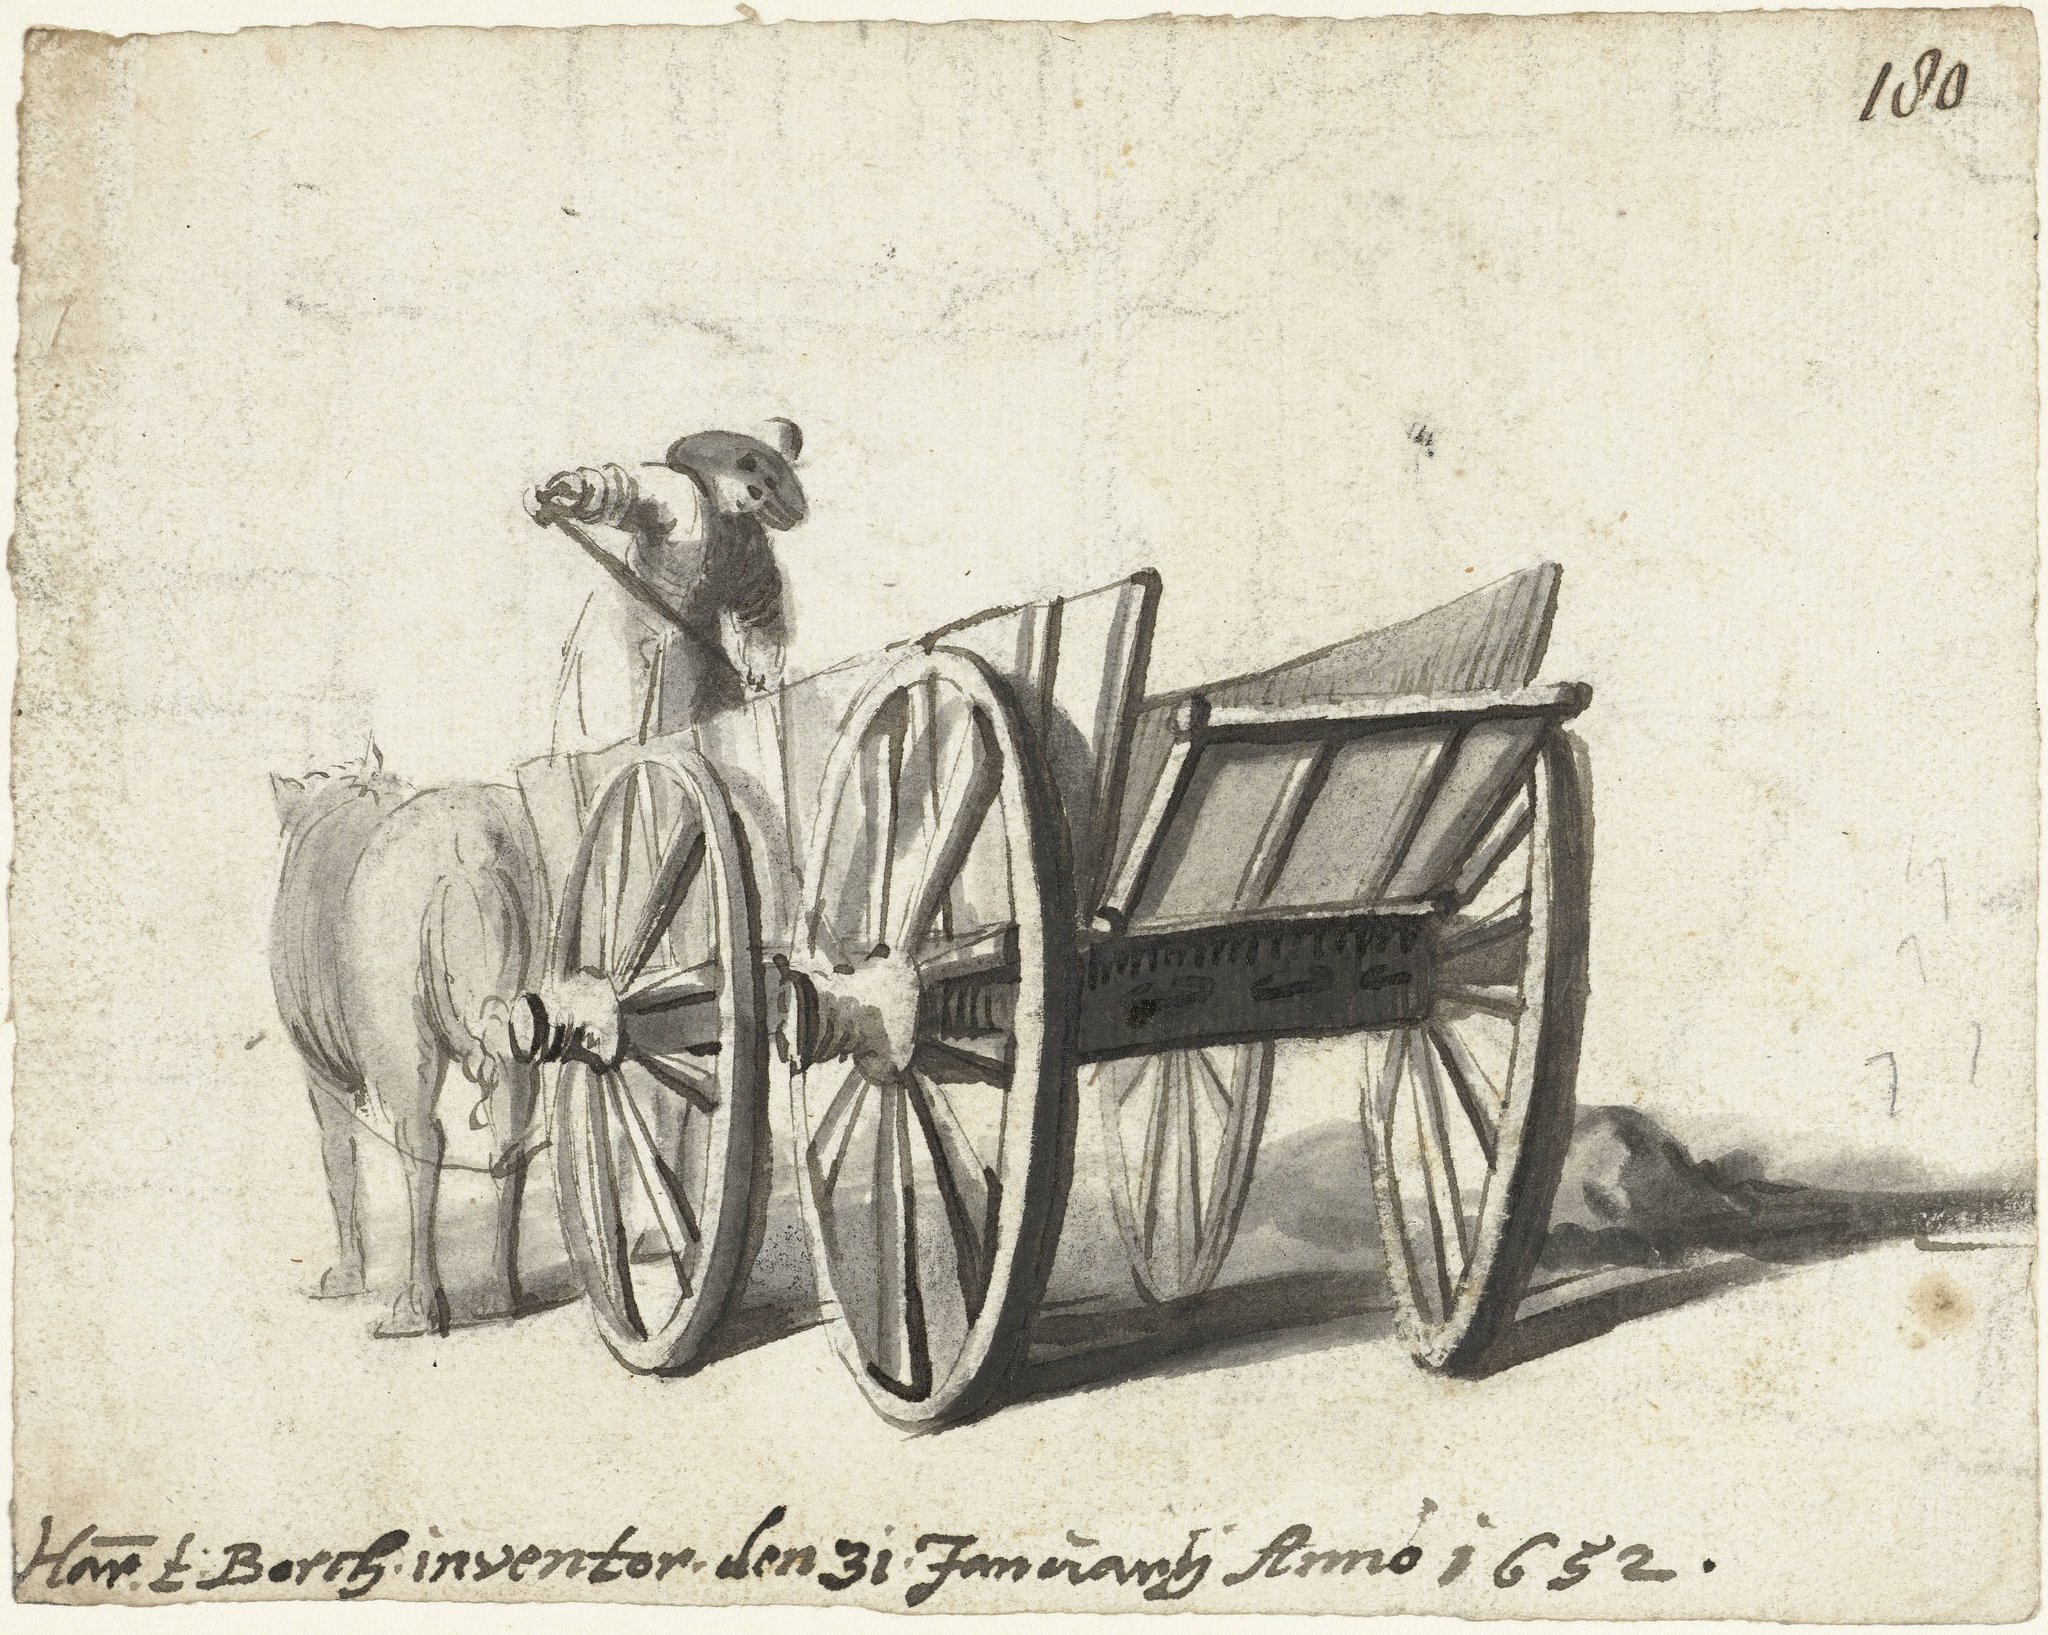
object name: drawing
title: Man werkend op een kar met paarden ervoor (mest scheppend?)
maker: harmen ter borch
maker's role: draughtsman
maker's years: 1638-1677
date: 1652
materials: ink, paper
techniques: brush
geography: zwolle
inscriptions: annotation: ‘Har[man].t.Borch. inventor. den 31.Januarij Anno 1652’